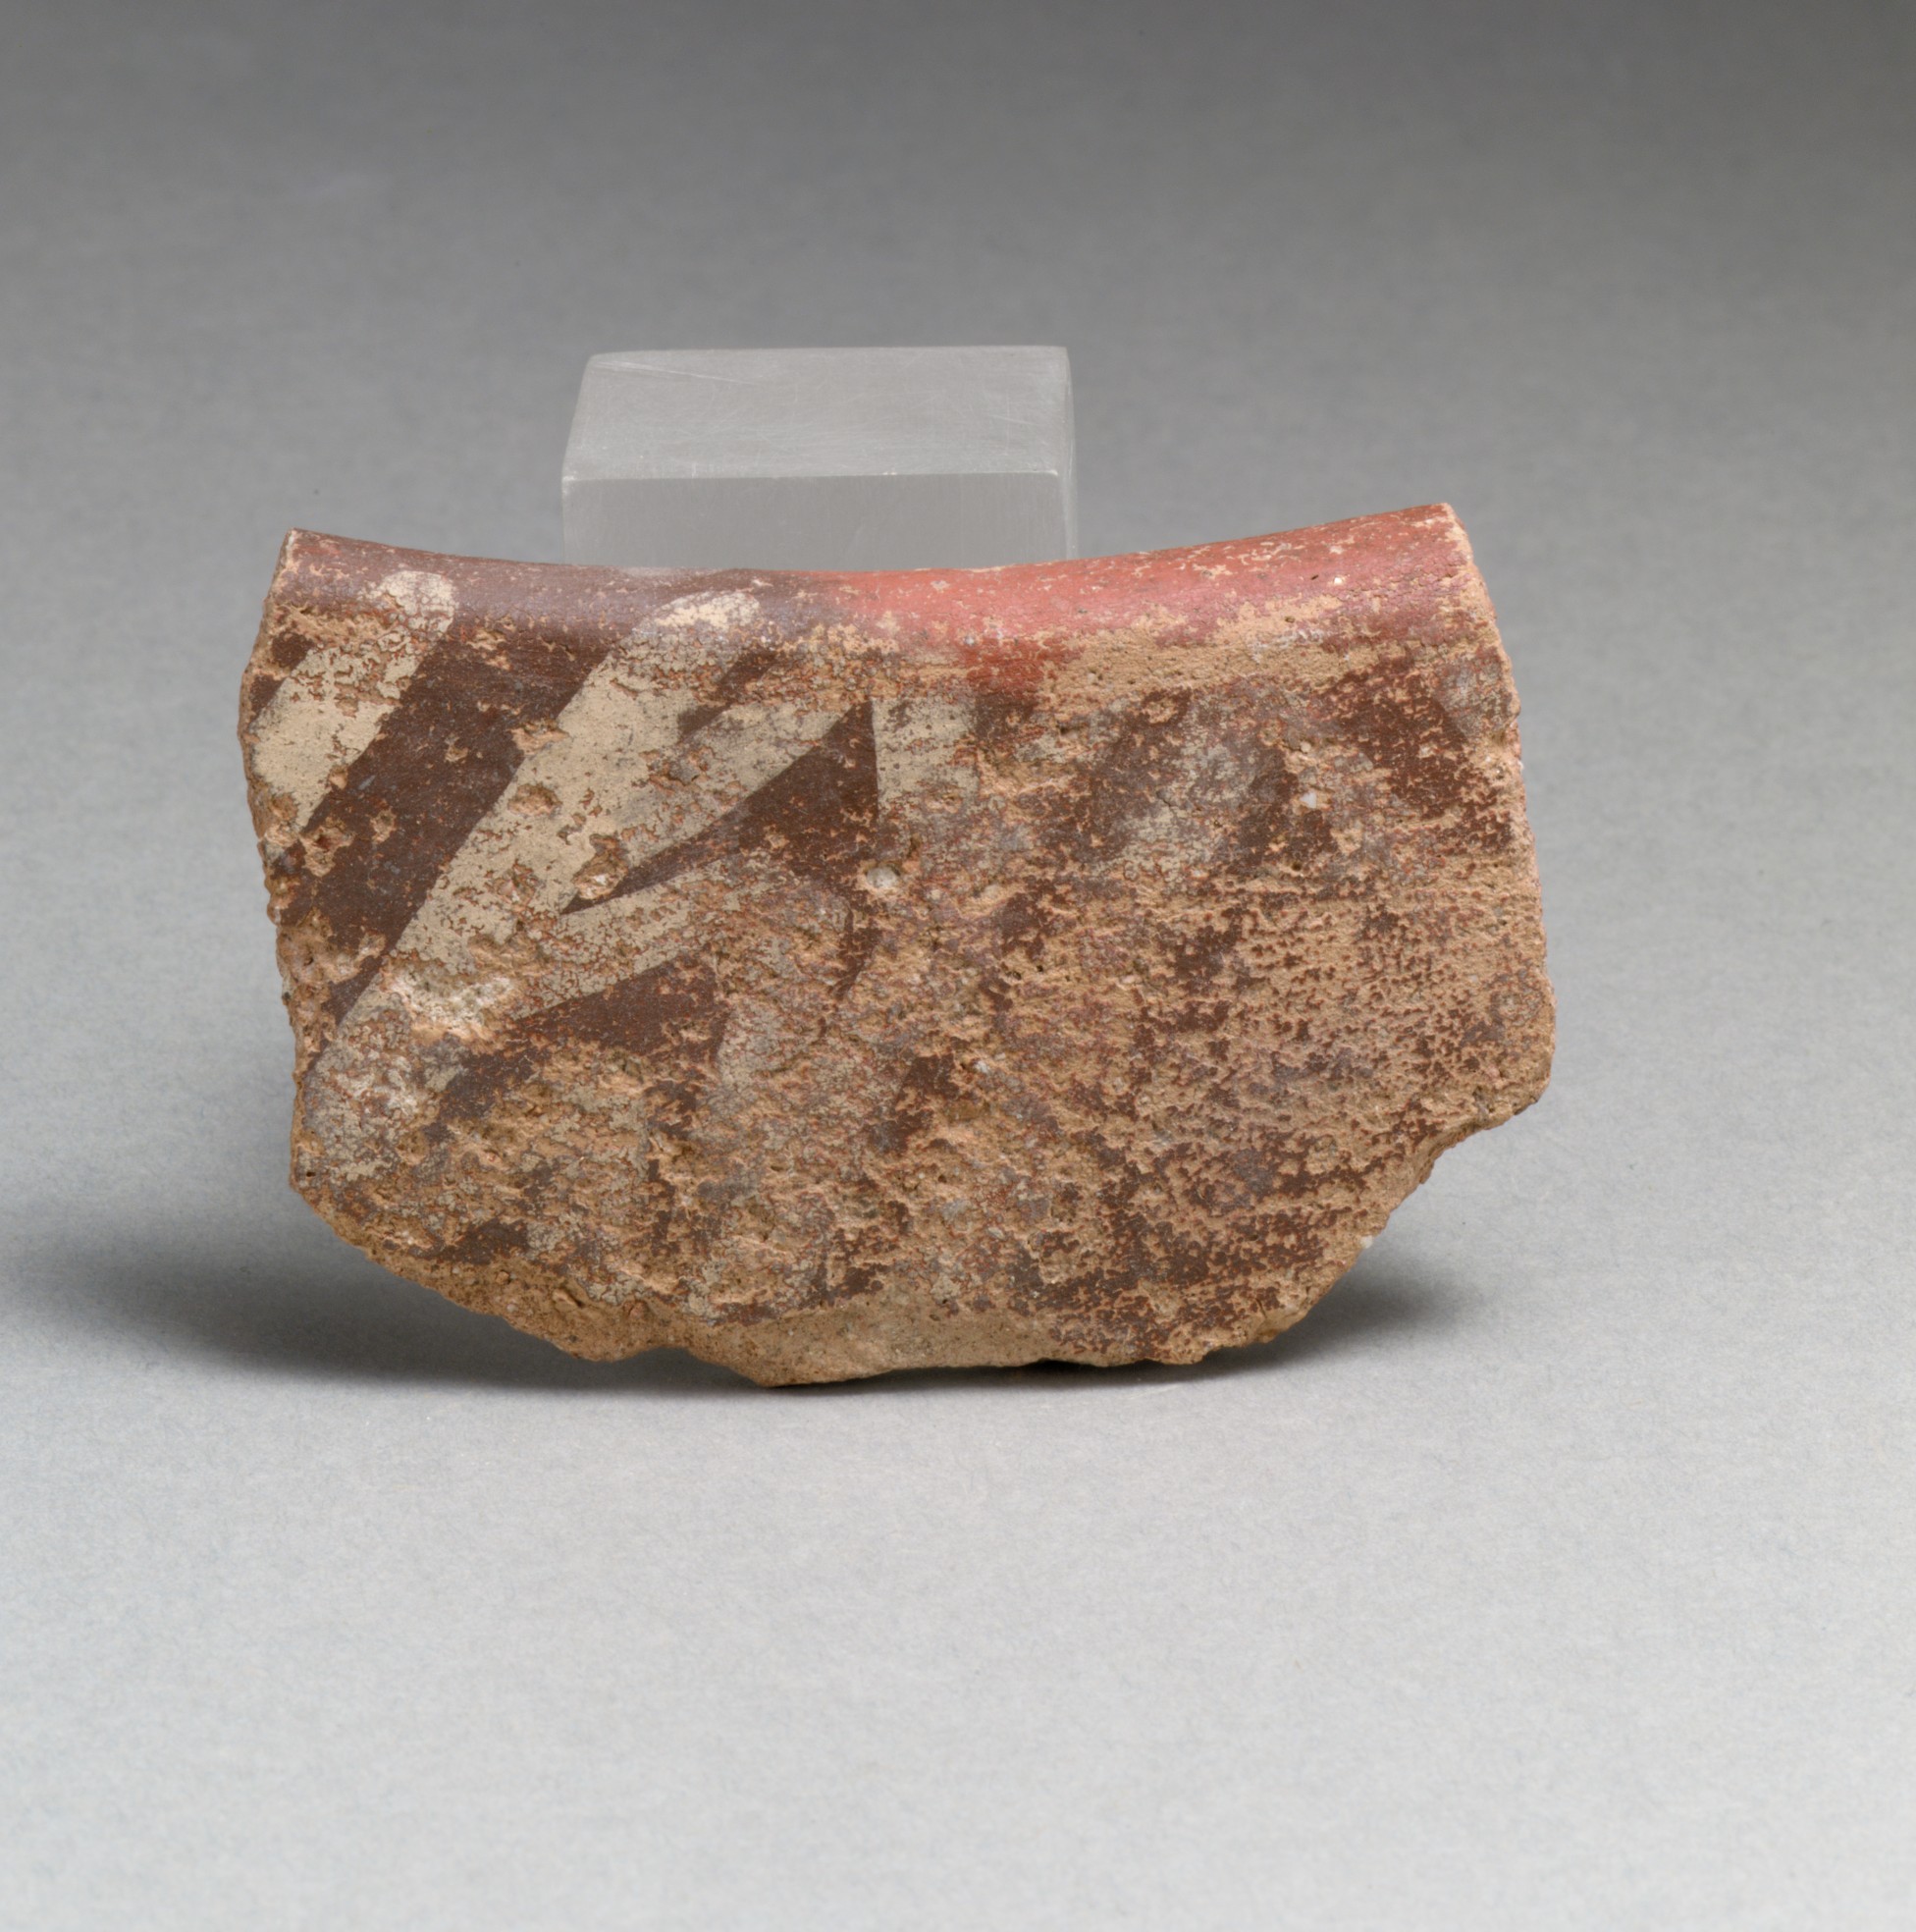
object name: vase fragment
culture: minoan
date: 2600-2000 BCE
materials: terracotta